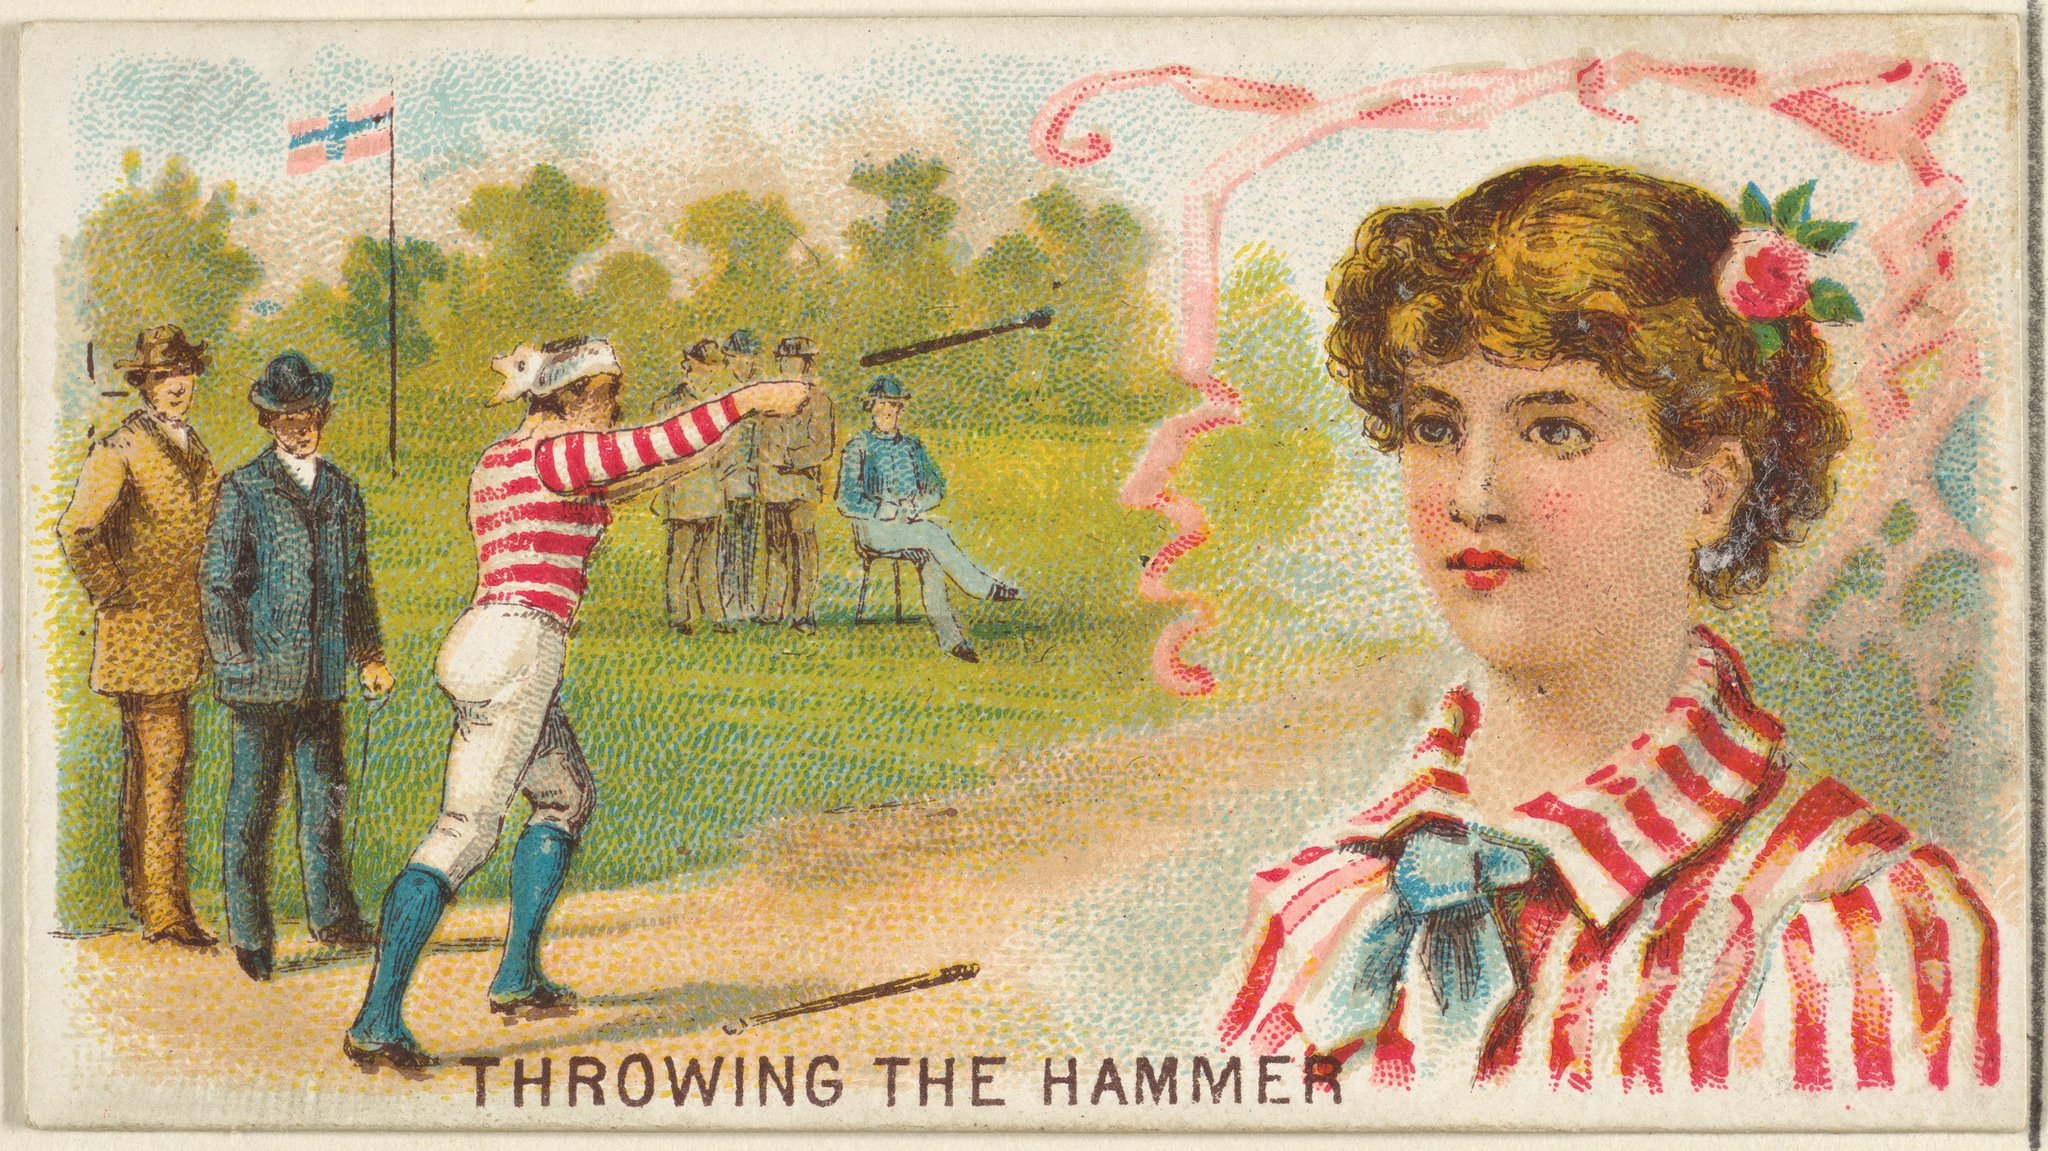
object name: print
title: Throwing the Hammer, from the Games and Sports series (N165) for Old Judge Cigarettes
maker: goodwin & company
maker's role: publisher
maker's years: 1850-1950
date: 1889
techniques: color lithograph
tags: men,women,sports